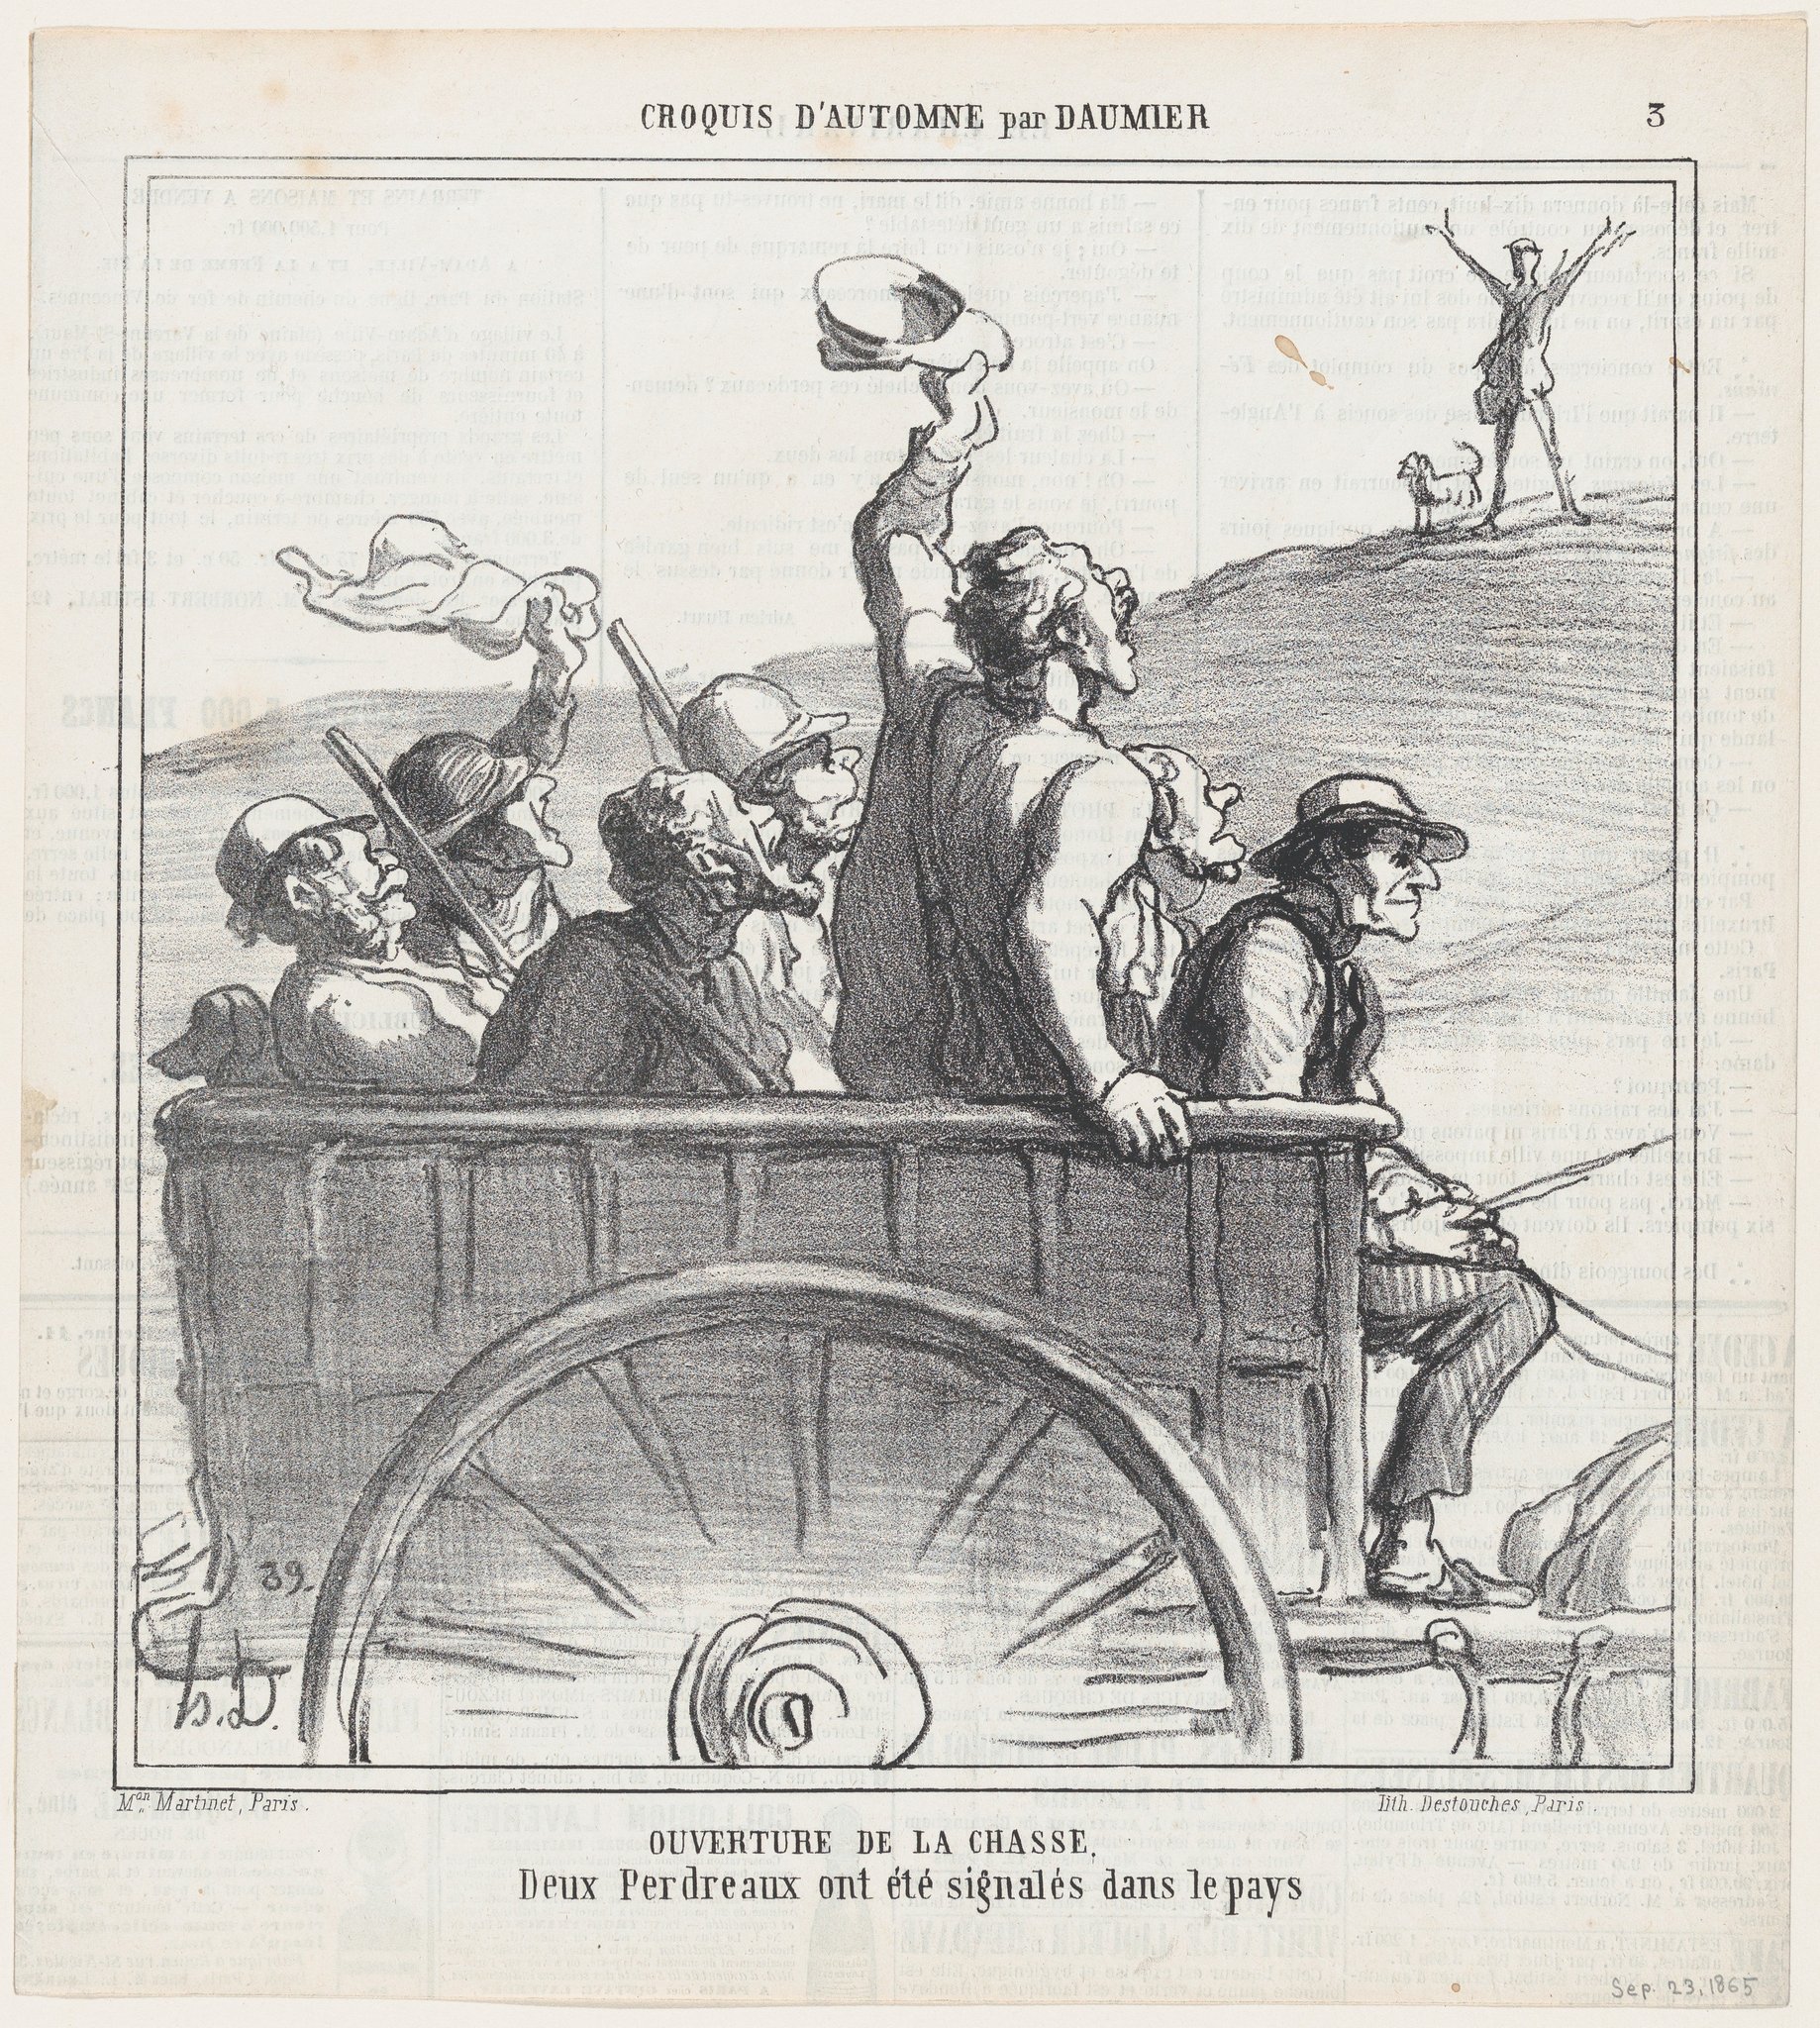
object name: print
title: Opening of hunting season, it seems that two partridges have been sighted in the area, from 'Autumn sketches,' published in Le Charivari, September 25, 1865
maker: honoré daumier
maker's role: artist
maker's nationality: french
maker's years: 1808-1879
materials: paper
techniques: lithograph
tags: men,carriages